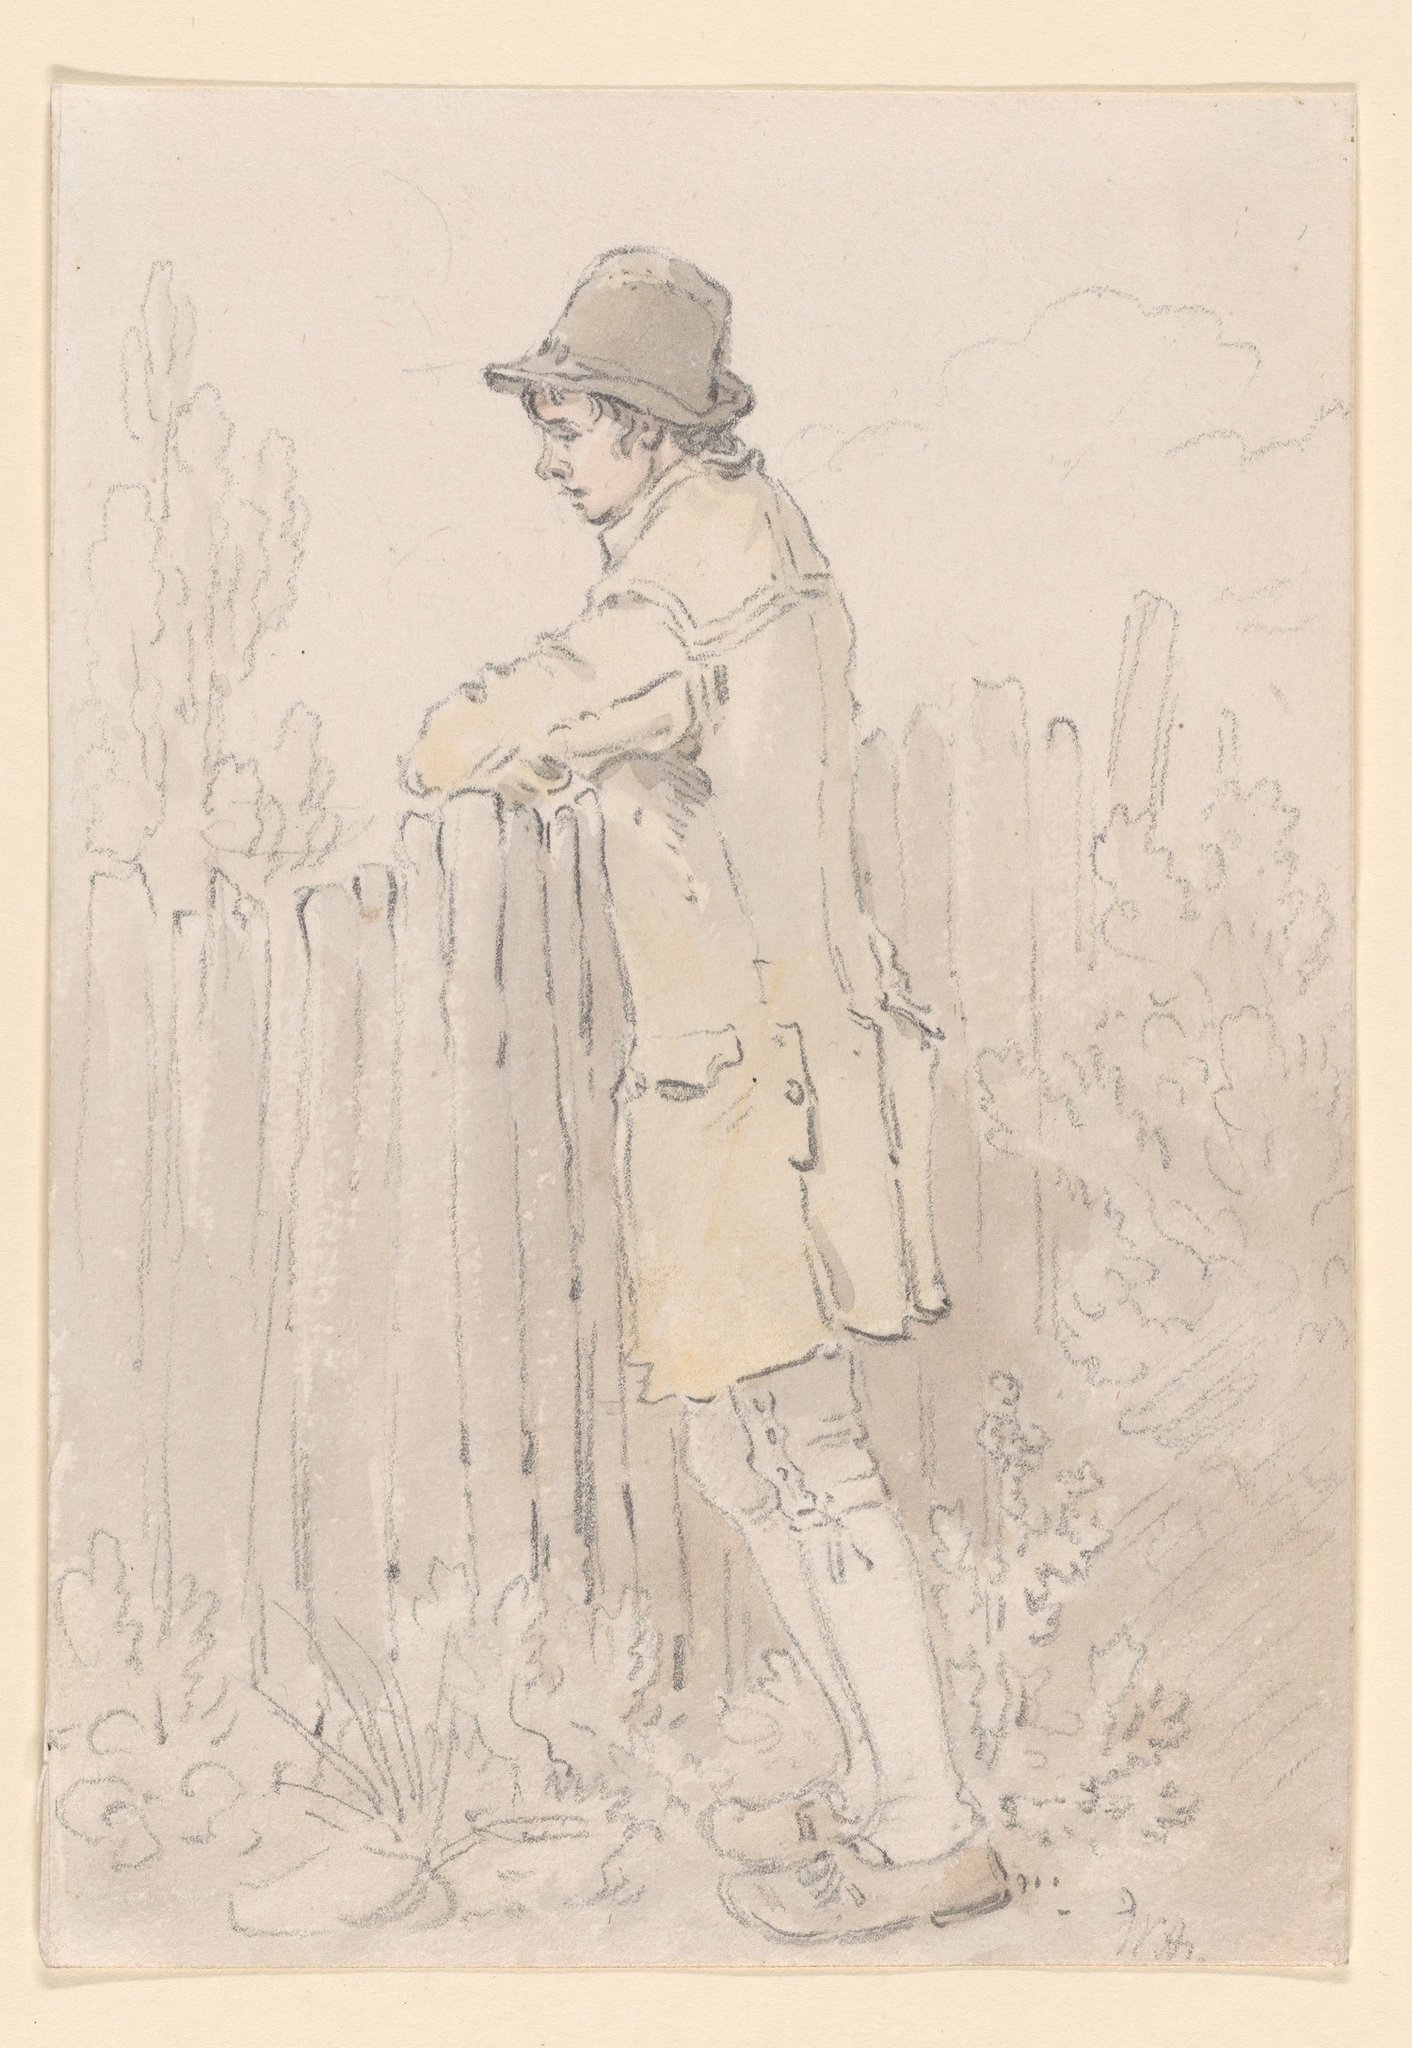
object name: drawing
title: A young man leaning on a fence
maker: william alexander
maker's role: artist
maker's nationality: british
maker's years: 1767-1816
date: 1785-1792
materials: graphite, watercolor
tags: fences,men